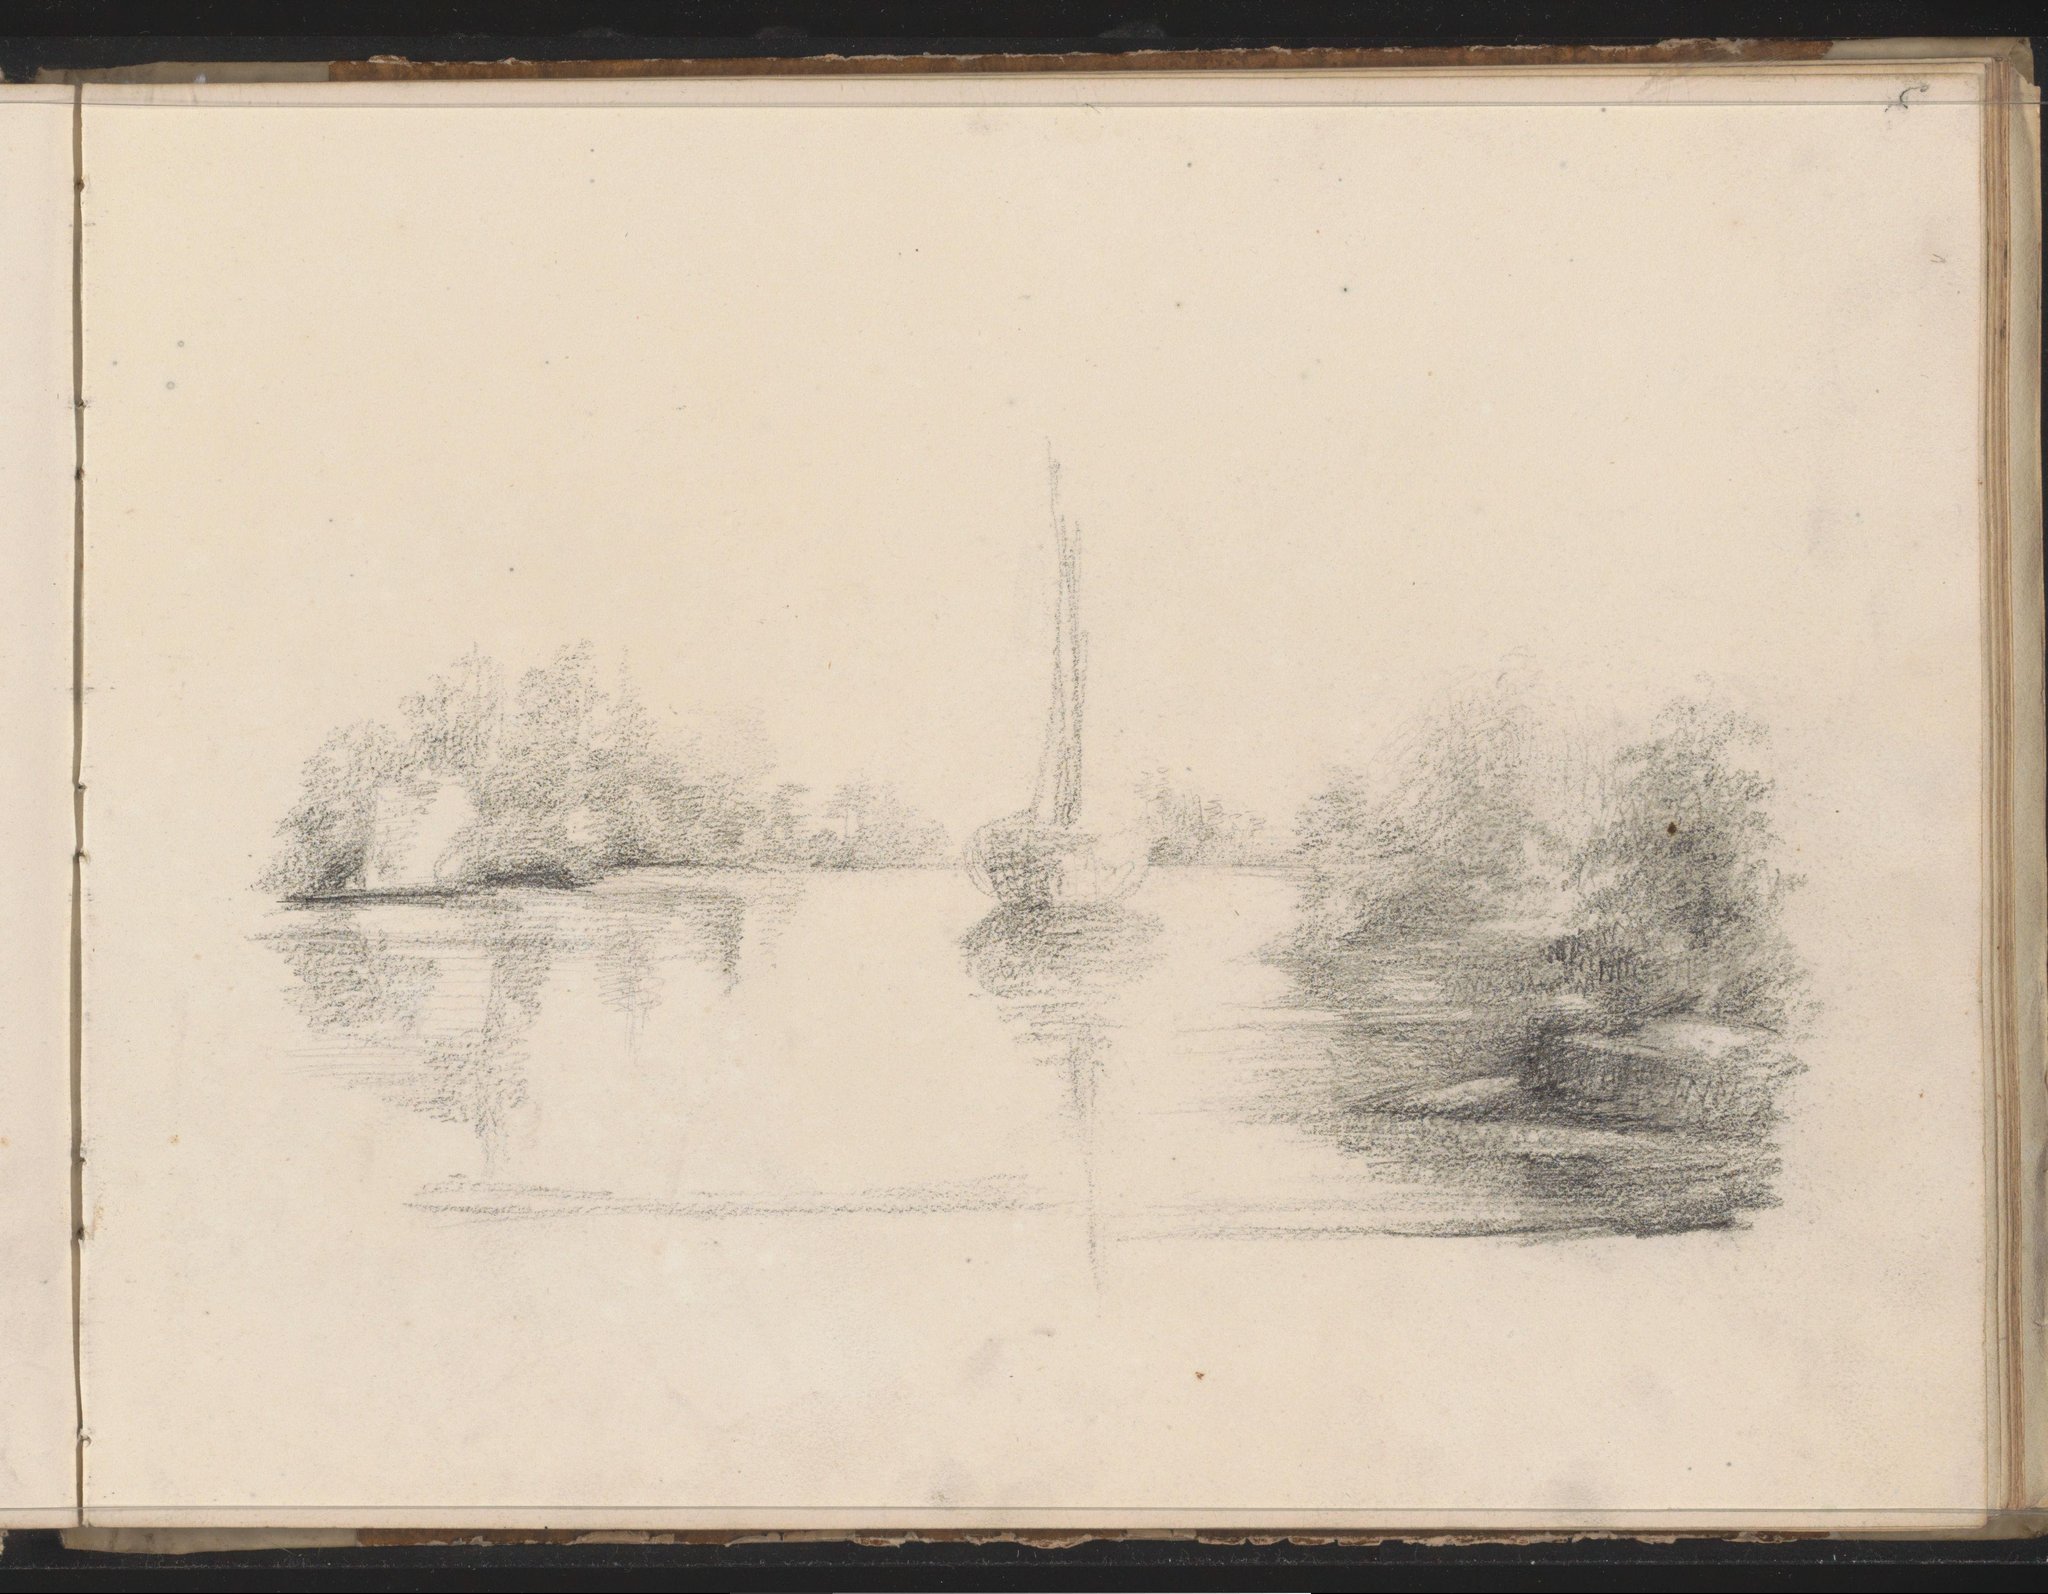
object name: sketchbook leaf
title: Zeilschip op een rivier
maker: maria vos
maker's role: draughtsman, painter, print maker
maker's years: 1824-1906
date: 1834-1906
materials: paper, pencil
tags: sailing-ship, sailing-boat, river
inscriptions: annotation: ‘S’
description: Blad 13 recto uit een schetsboek met 39 bladen.